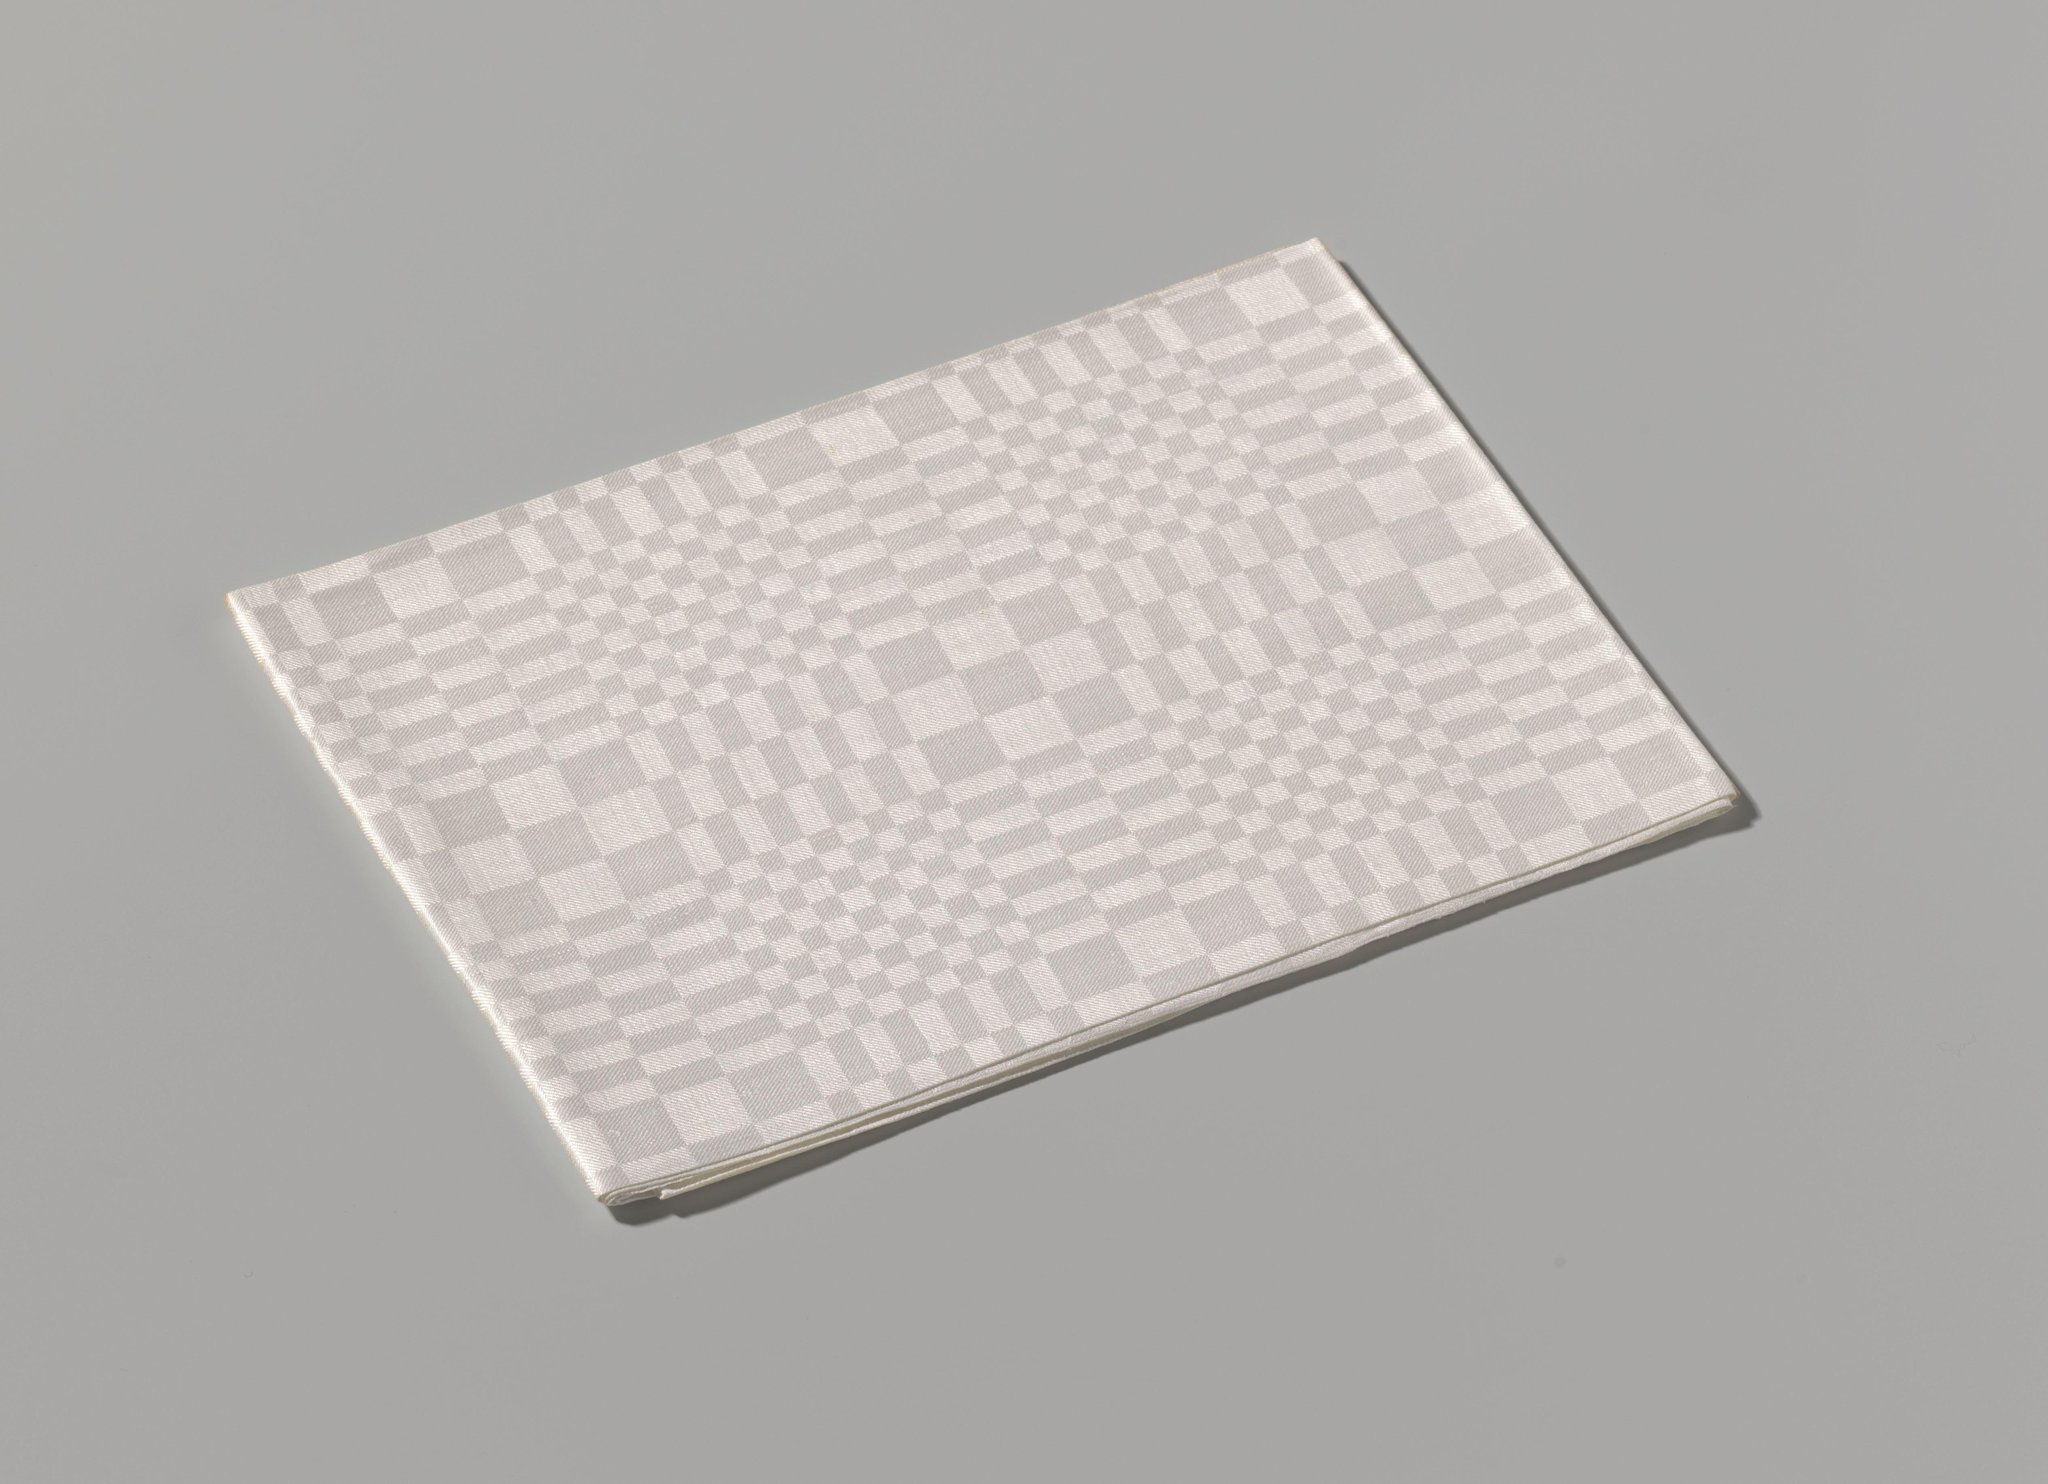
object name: napkin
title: Servet van pellendamast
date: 1739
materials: linen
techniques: weave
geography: northern netherlands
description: Wit linnen servet met pellenpatroon, genaamd "Engelse garderobe". Merk kroon WG 36 1739.